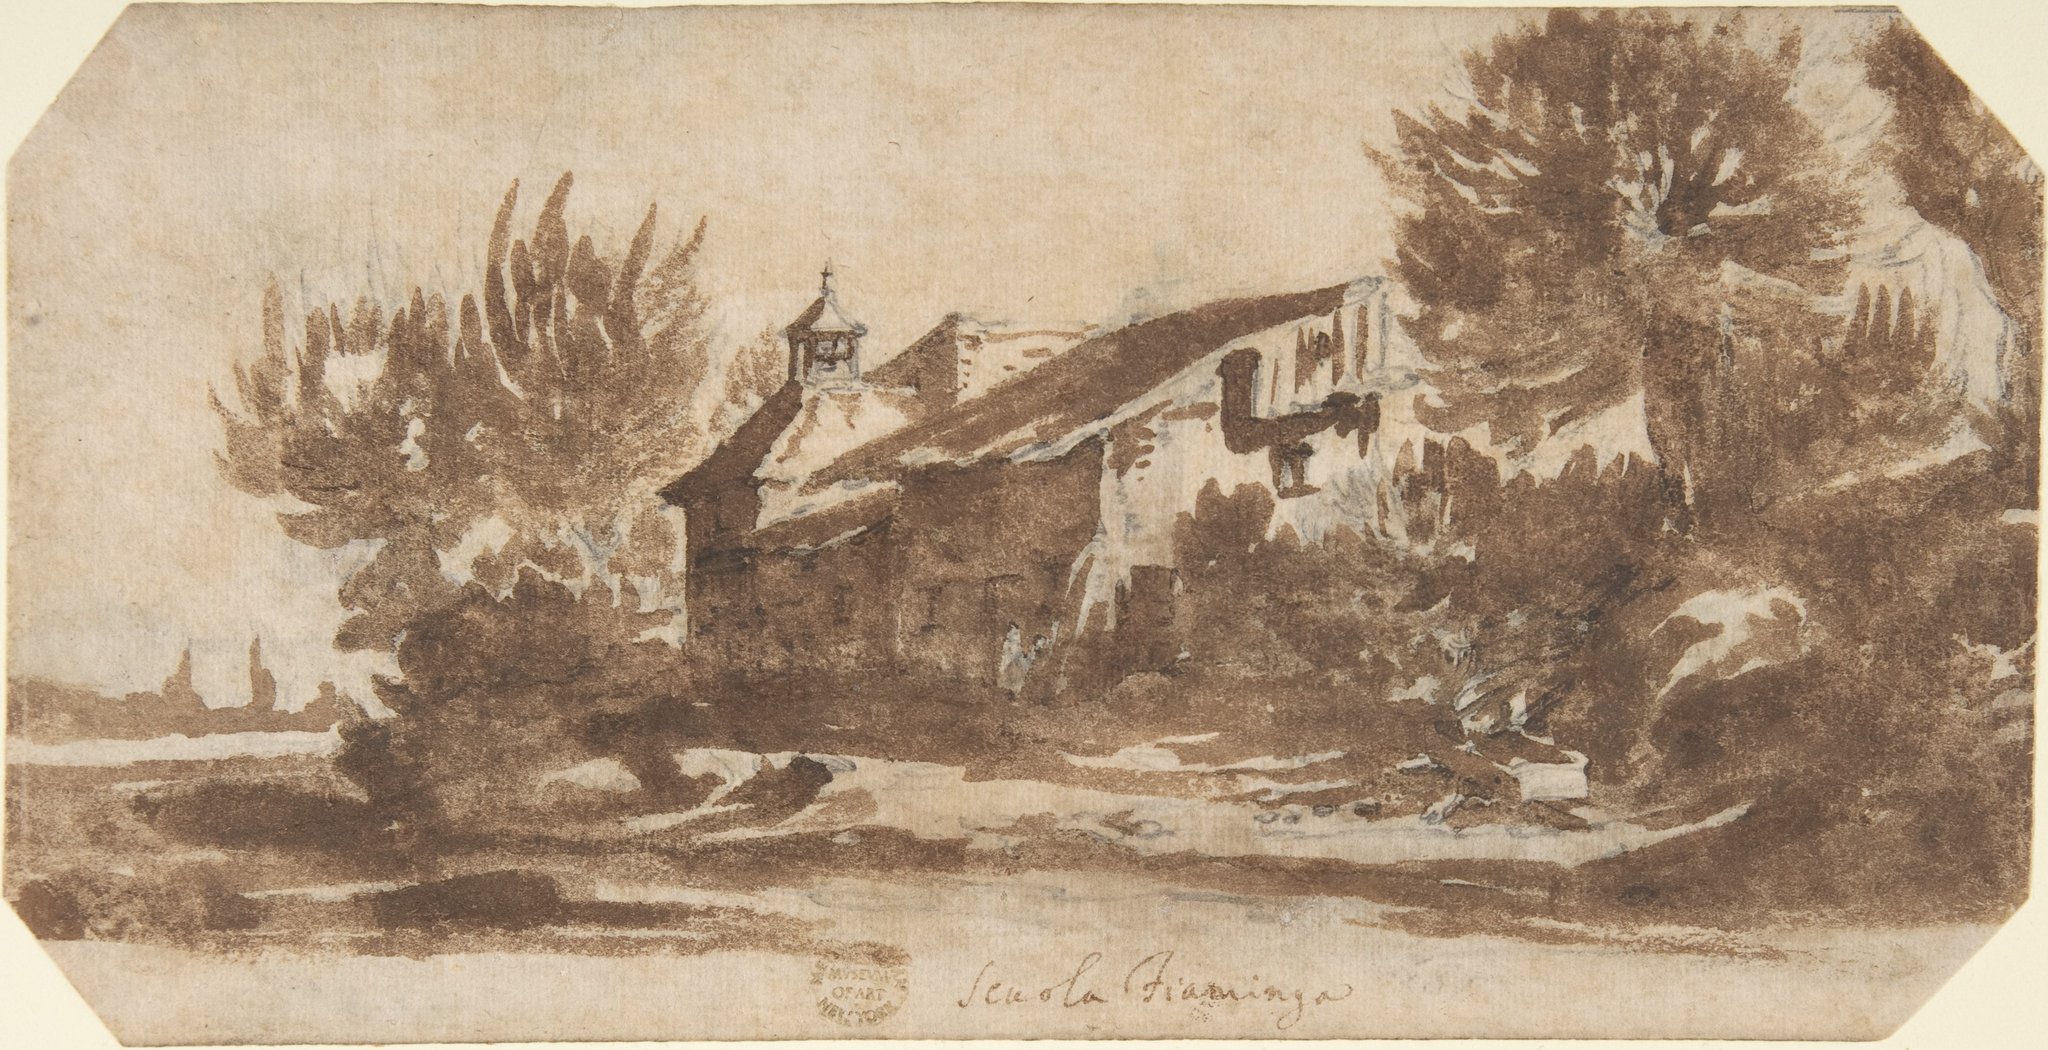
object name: drawing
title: Landscape with a Country Chapel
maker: jacques callot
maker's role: artist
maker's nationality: french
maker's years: 1592-1635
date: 1605-1635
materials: chalk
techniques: brush, wash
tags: landscapes,trees